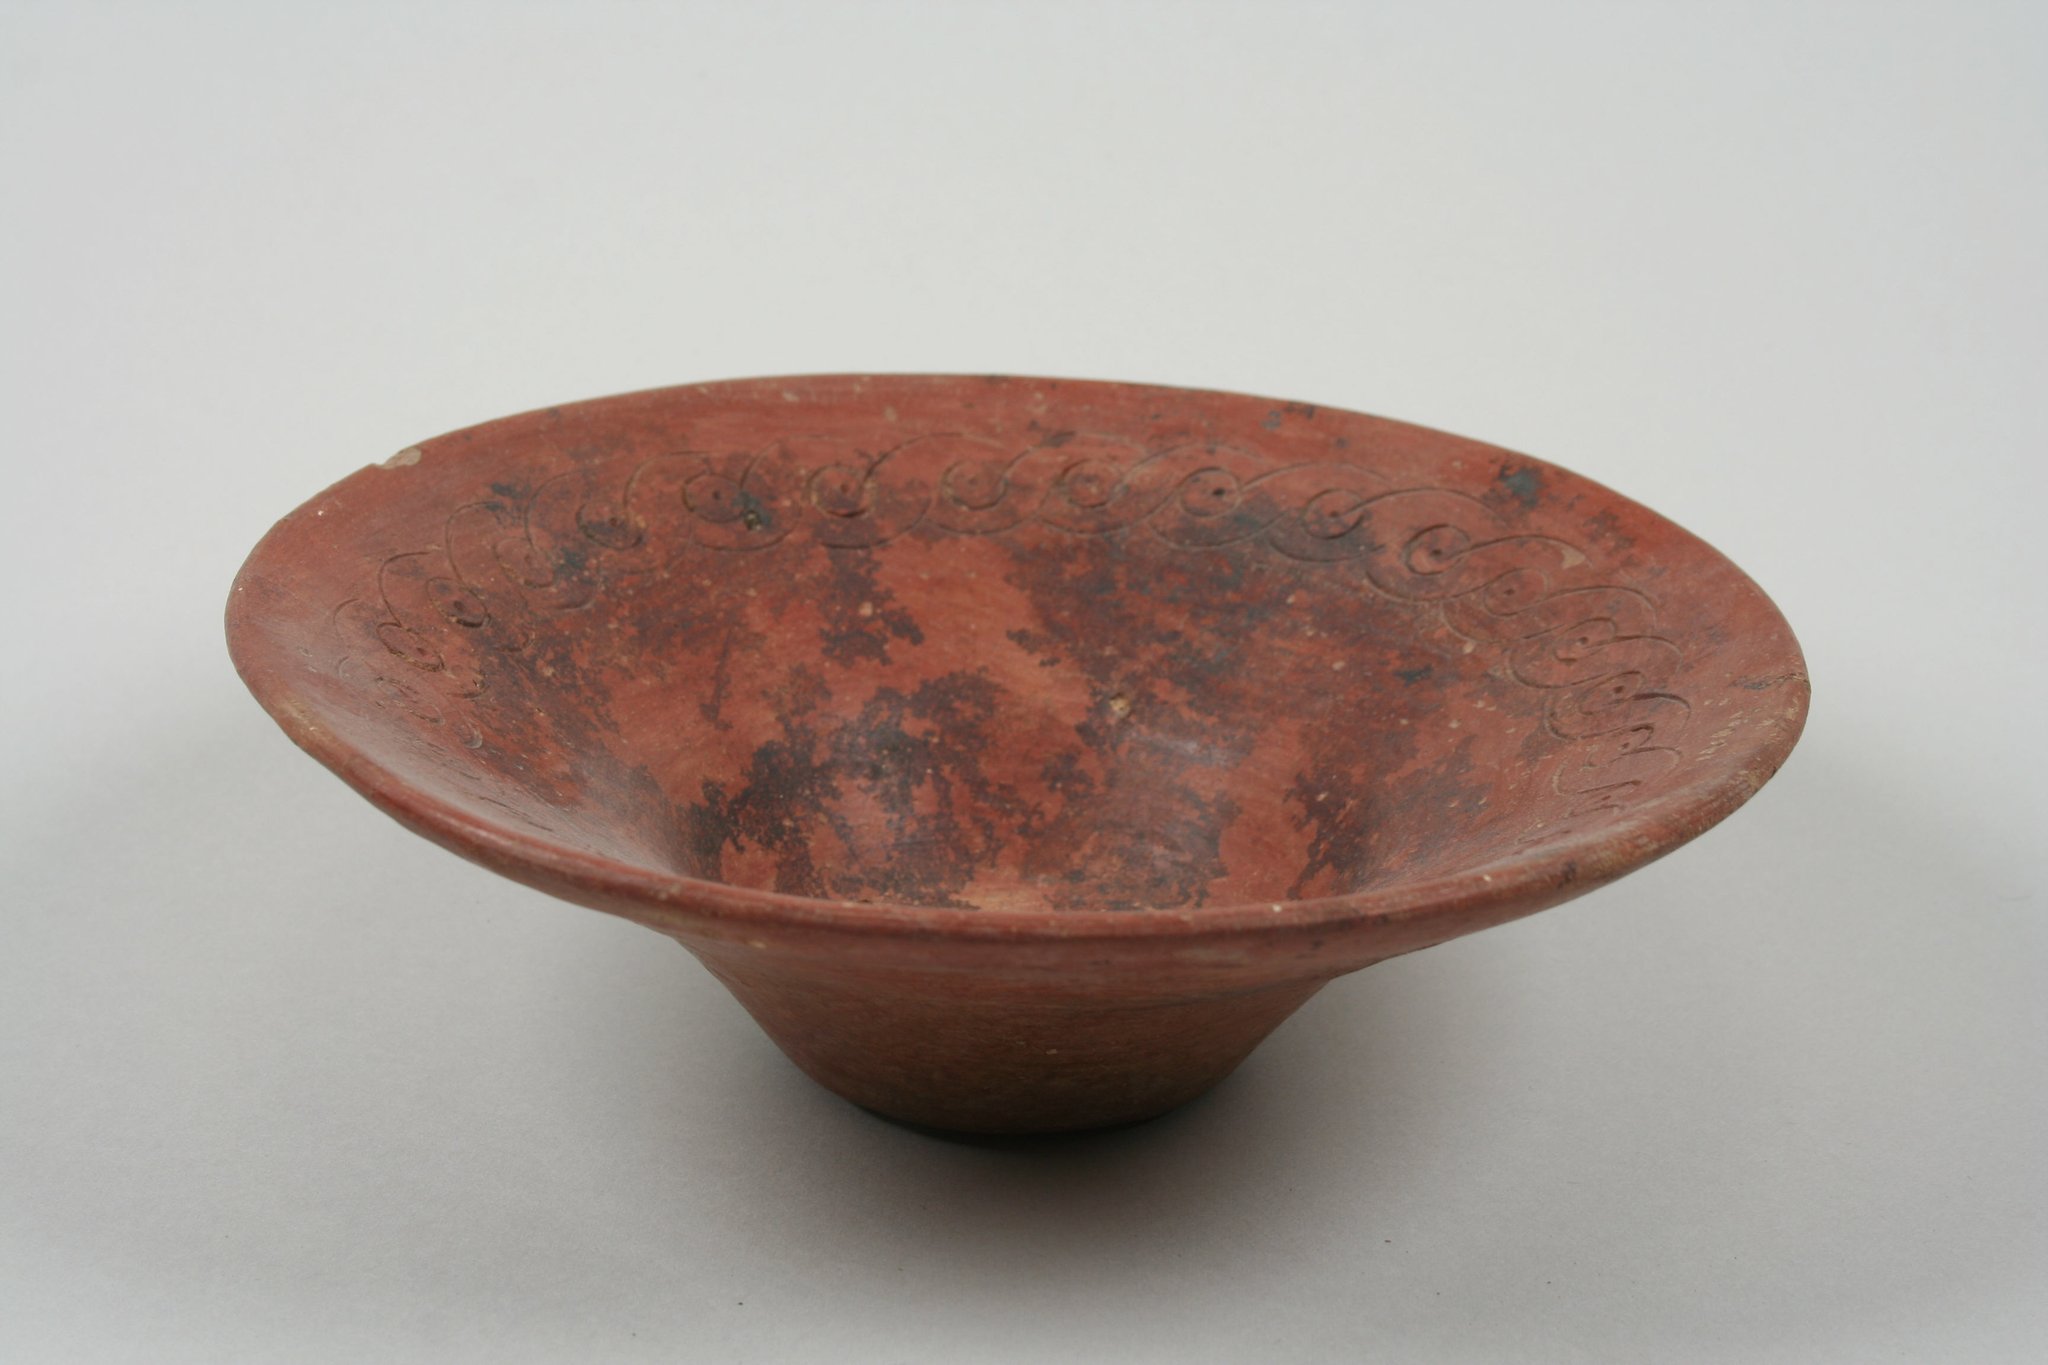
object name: bowl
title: Bowl with Figure Eight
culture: paracas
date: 700-301 BCE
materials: ceramic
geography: peru